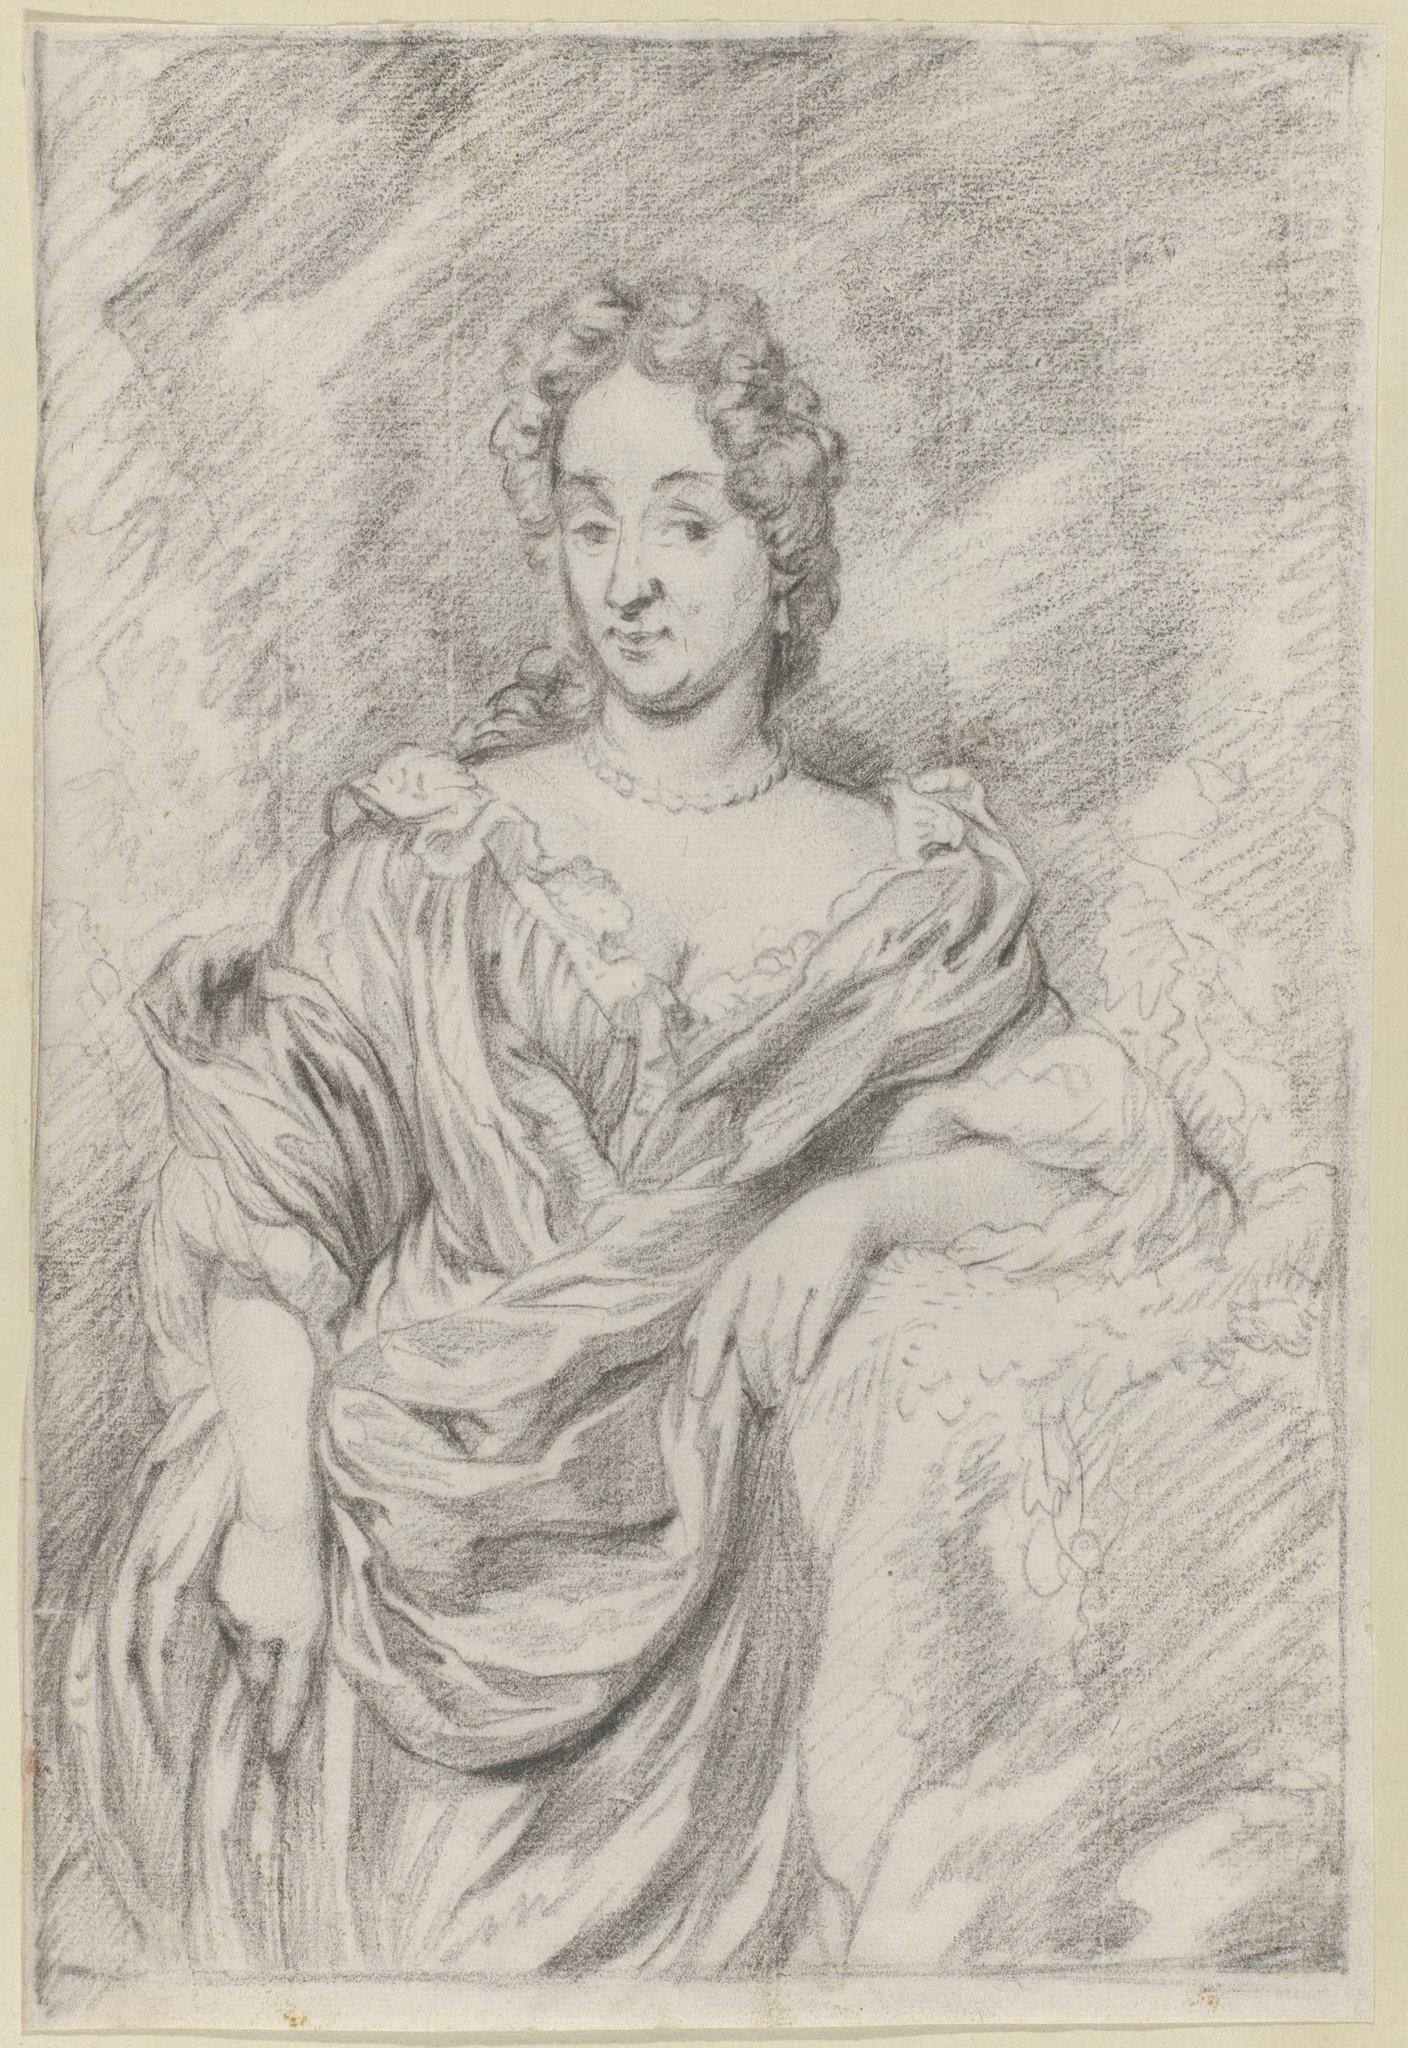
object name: drawing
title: Rijk geklede staande vrouw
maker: Anonymous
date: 1675-1725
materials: chalk, paper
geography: netherlands